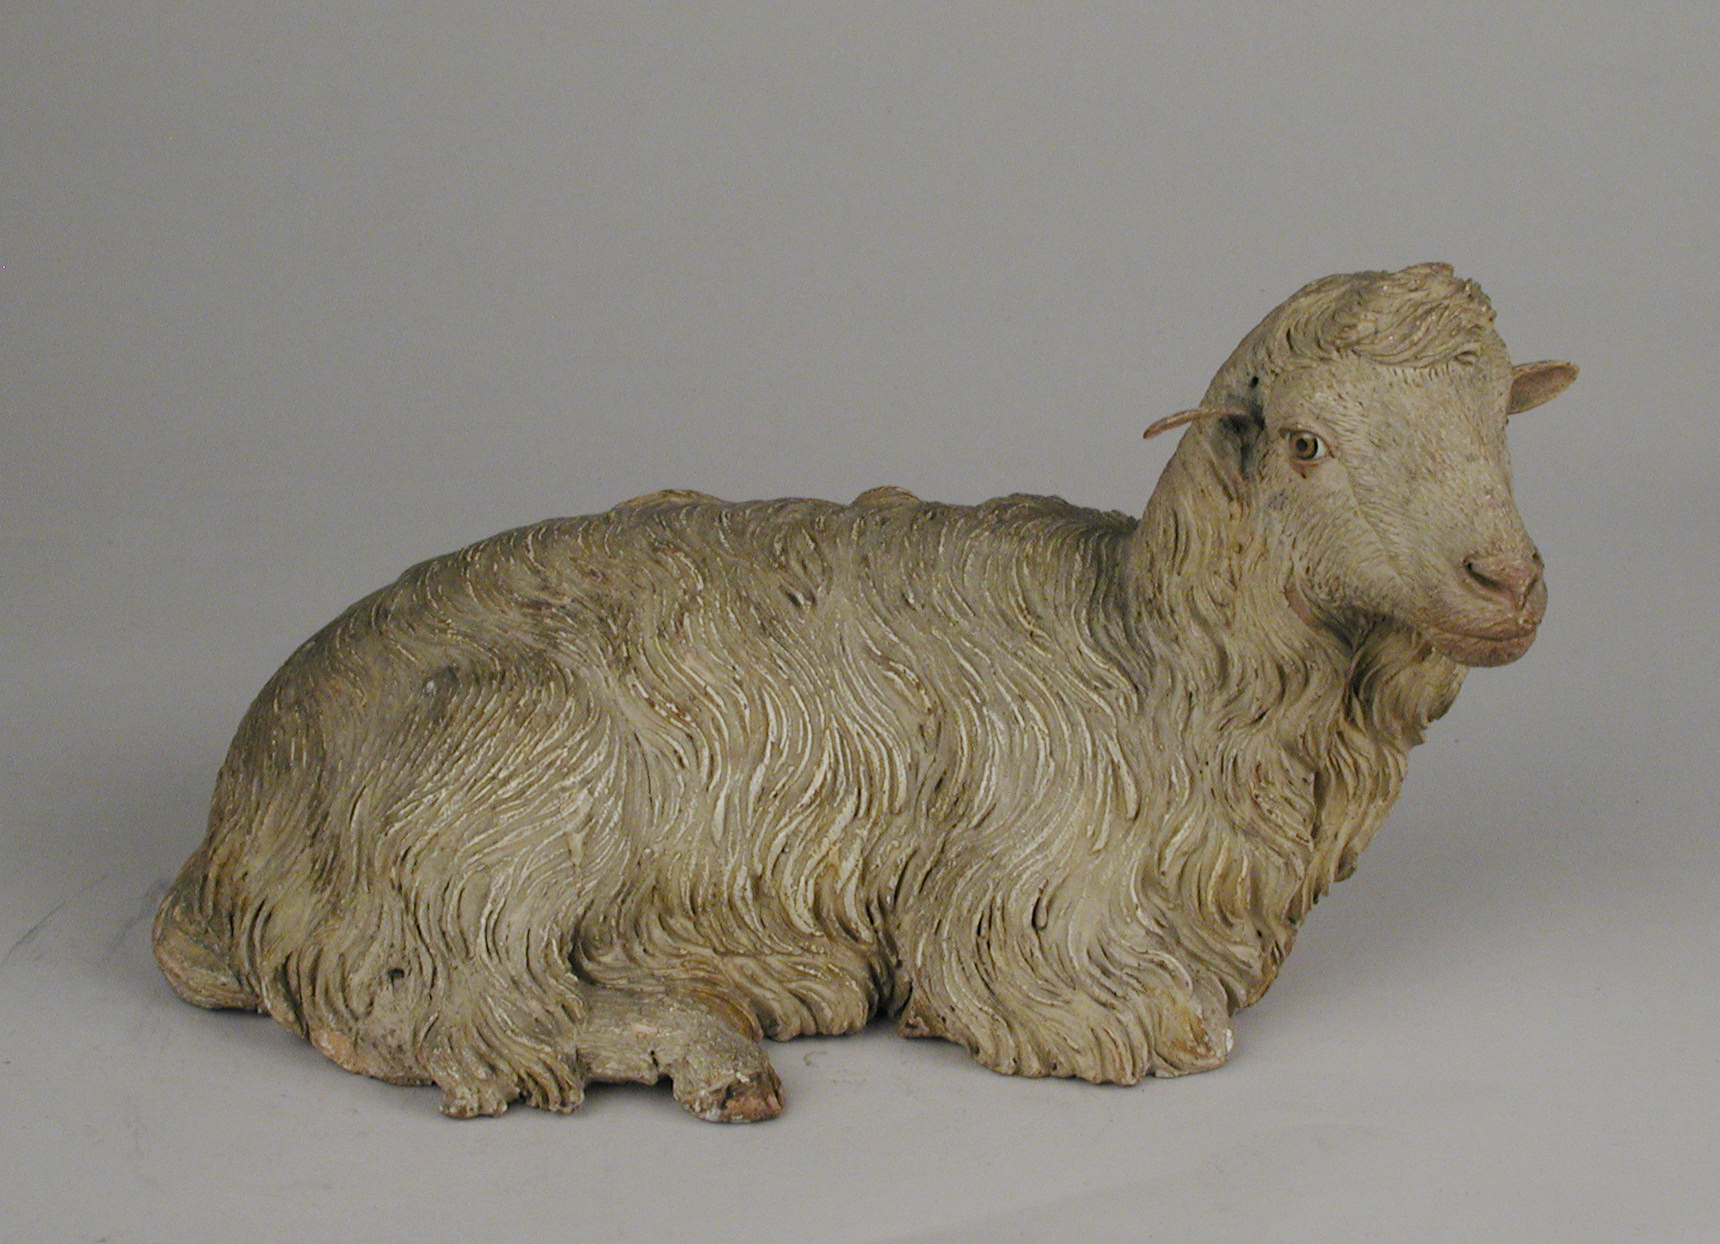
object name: crèche figure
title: Seated sheep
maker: nicola vassalo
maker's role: maker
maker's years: 1725-1825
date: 1751-1800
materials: terracotta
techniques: polychrome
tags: sheep